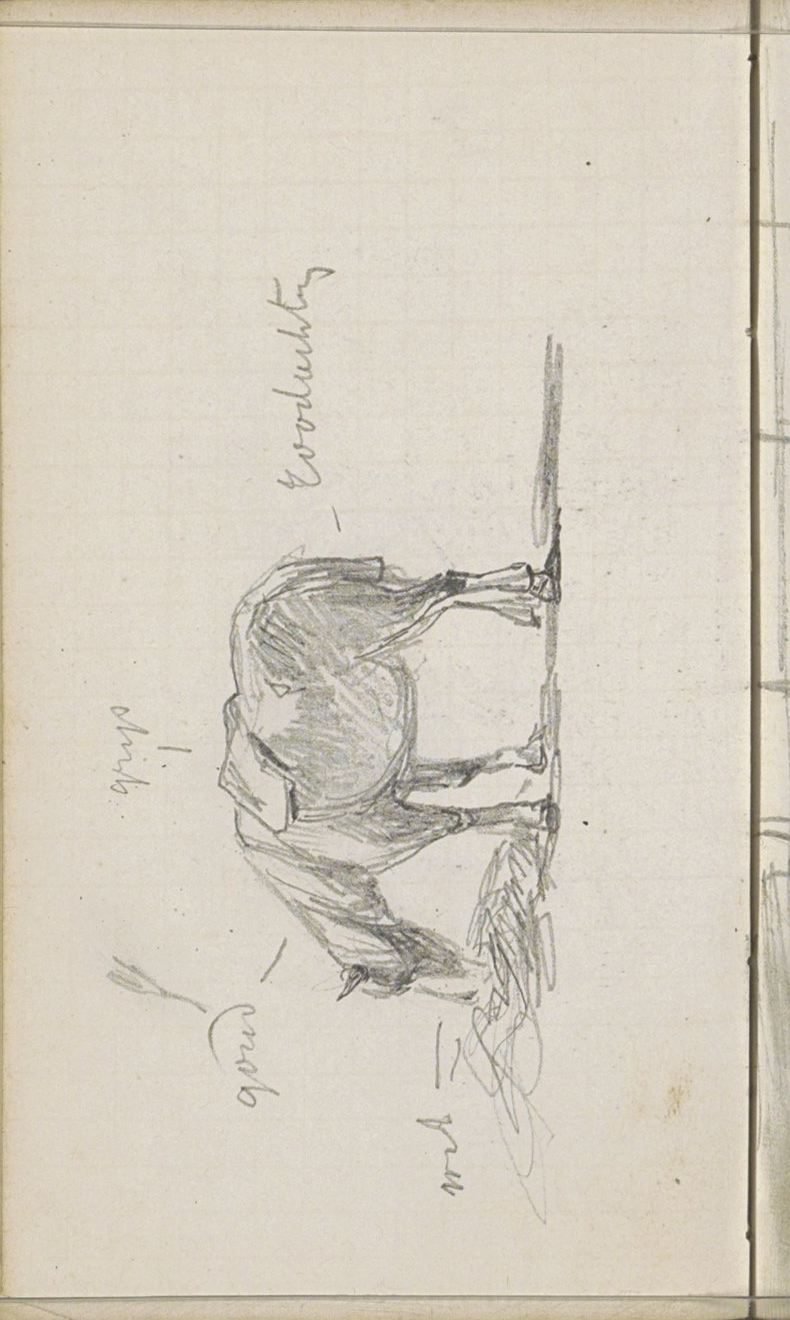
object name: sketchbook leaf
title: Grazend paard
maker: jan willem van borselen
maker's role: draughtsman, print maker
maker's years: 1825-1892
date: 1868-1887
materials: pencil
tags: horse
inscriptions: kleurnotitie, handgeschreven in potlood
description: Blad 35 verso uit een schetsboek met 51 bladen.